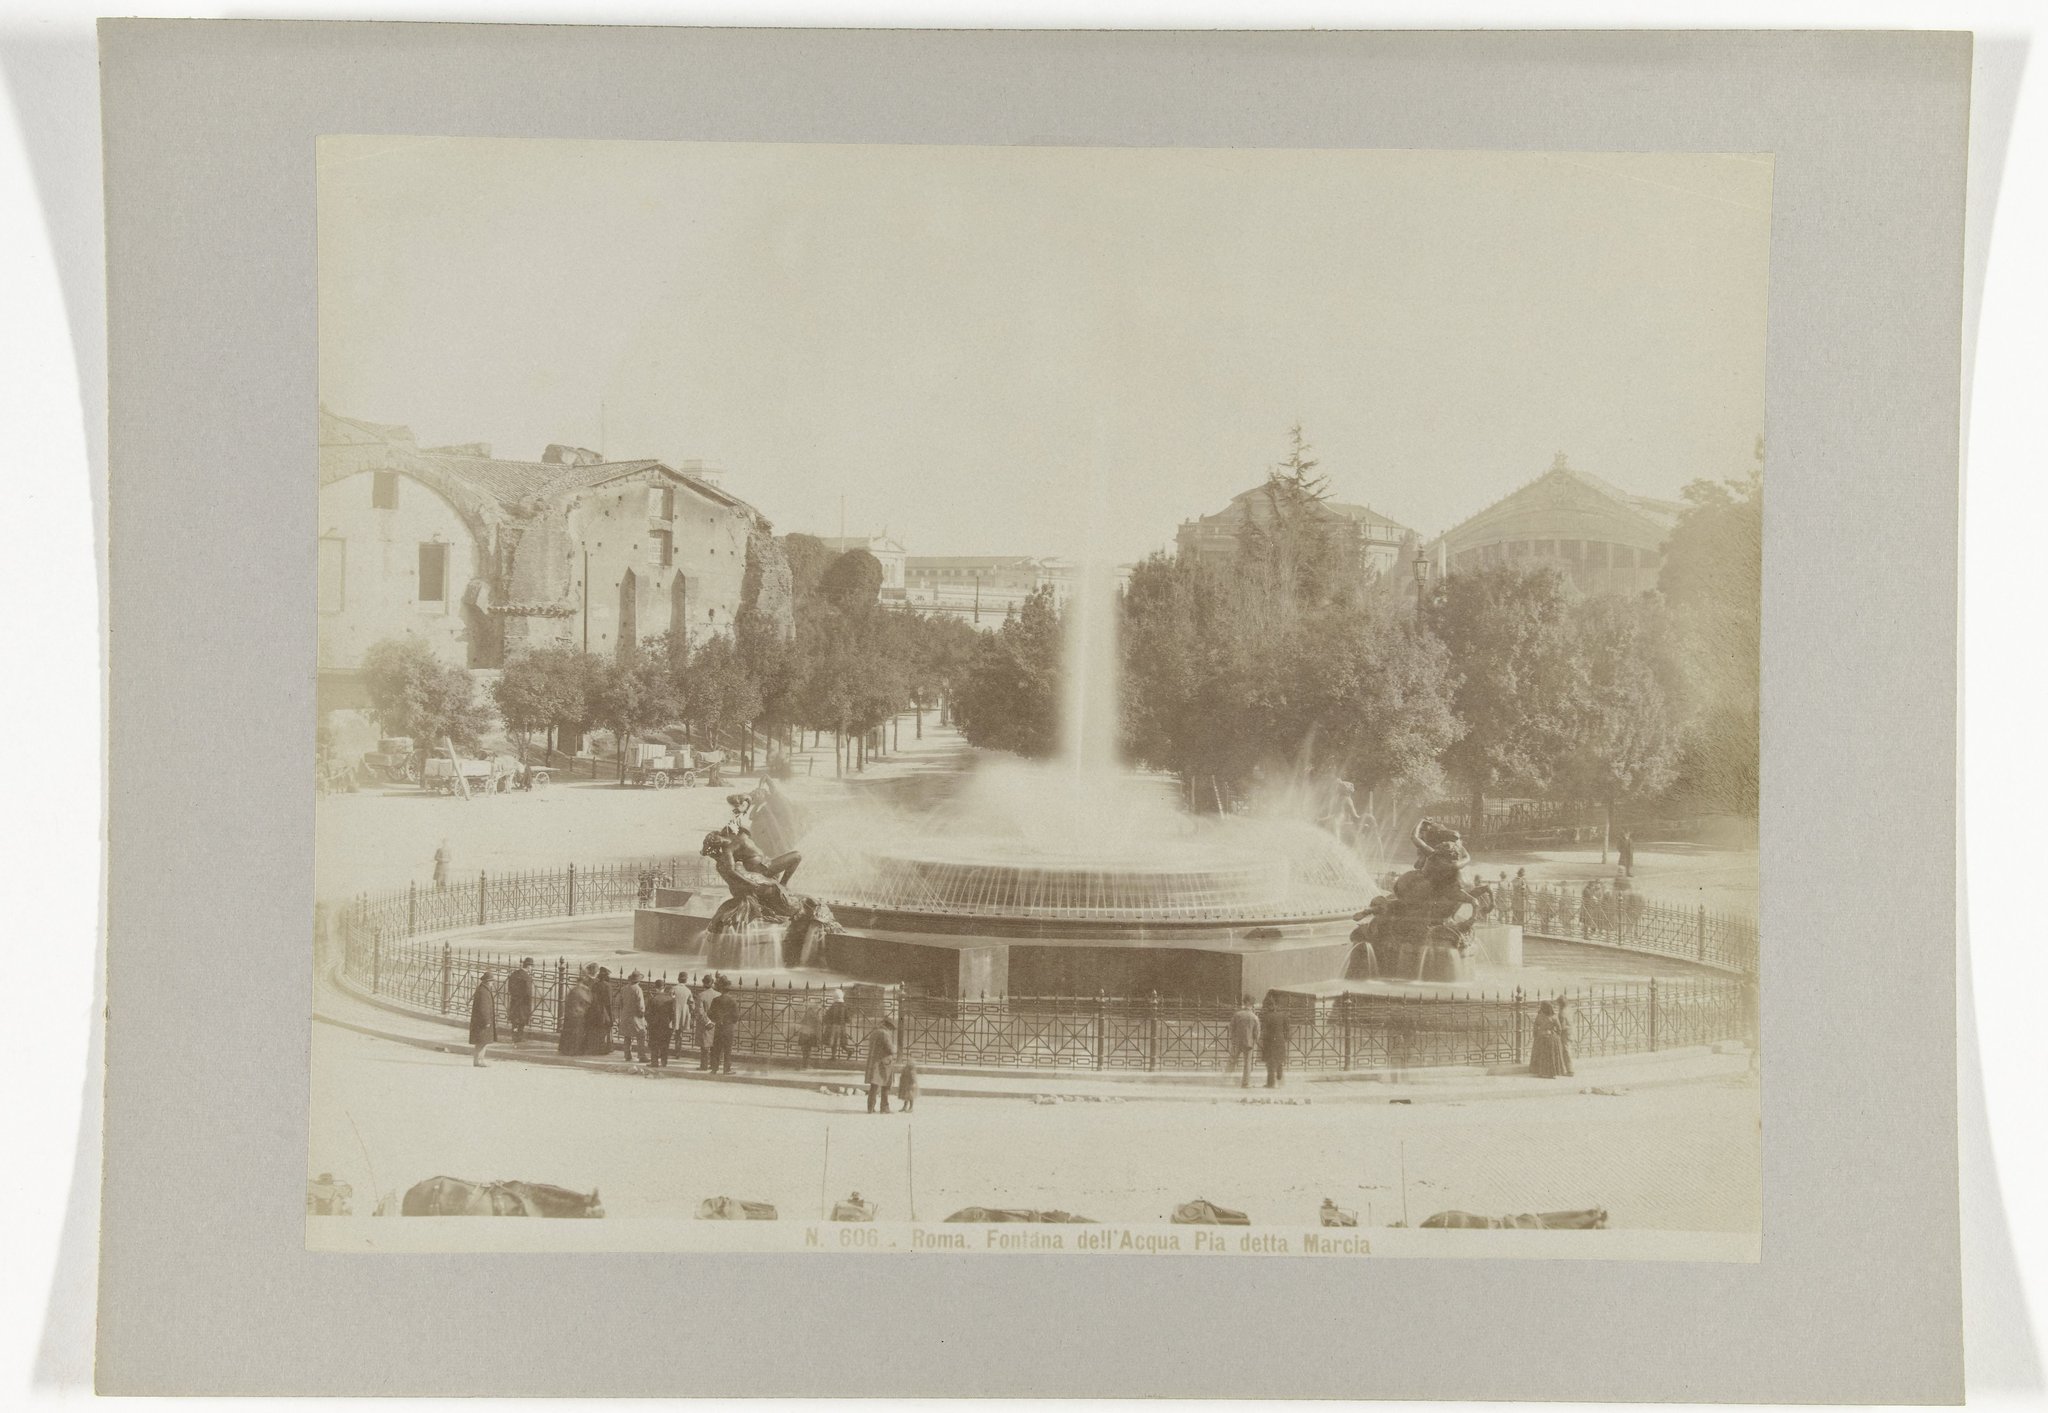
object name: photograph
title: N. 606, Roma. Fontana dell' Acqua Pia detta Marcia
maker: Anonymous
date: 1880-1895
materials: cardboard, paper, photographic support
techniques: albumen print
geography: rome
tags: rome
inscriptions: number: ‘4.’